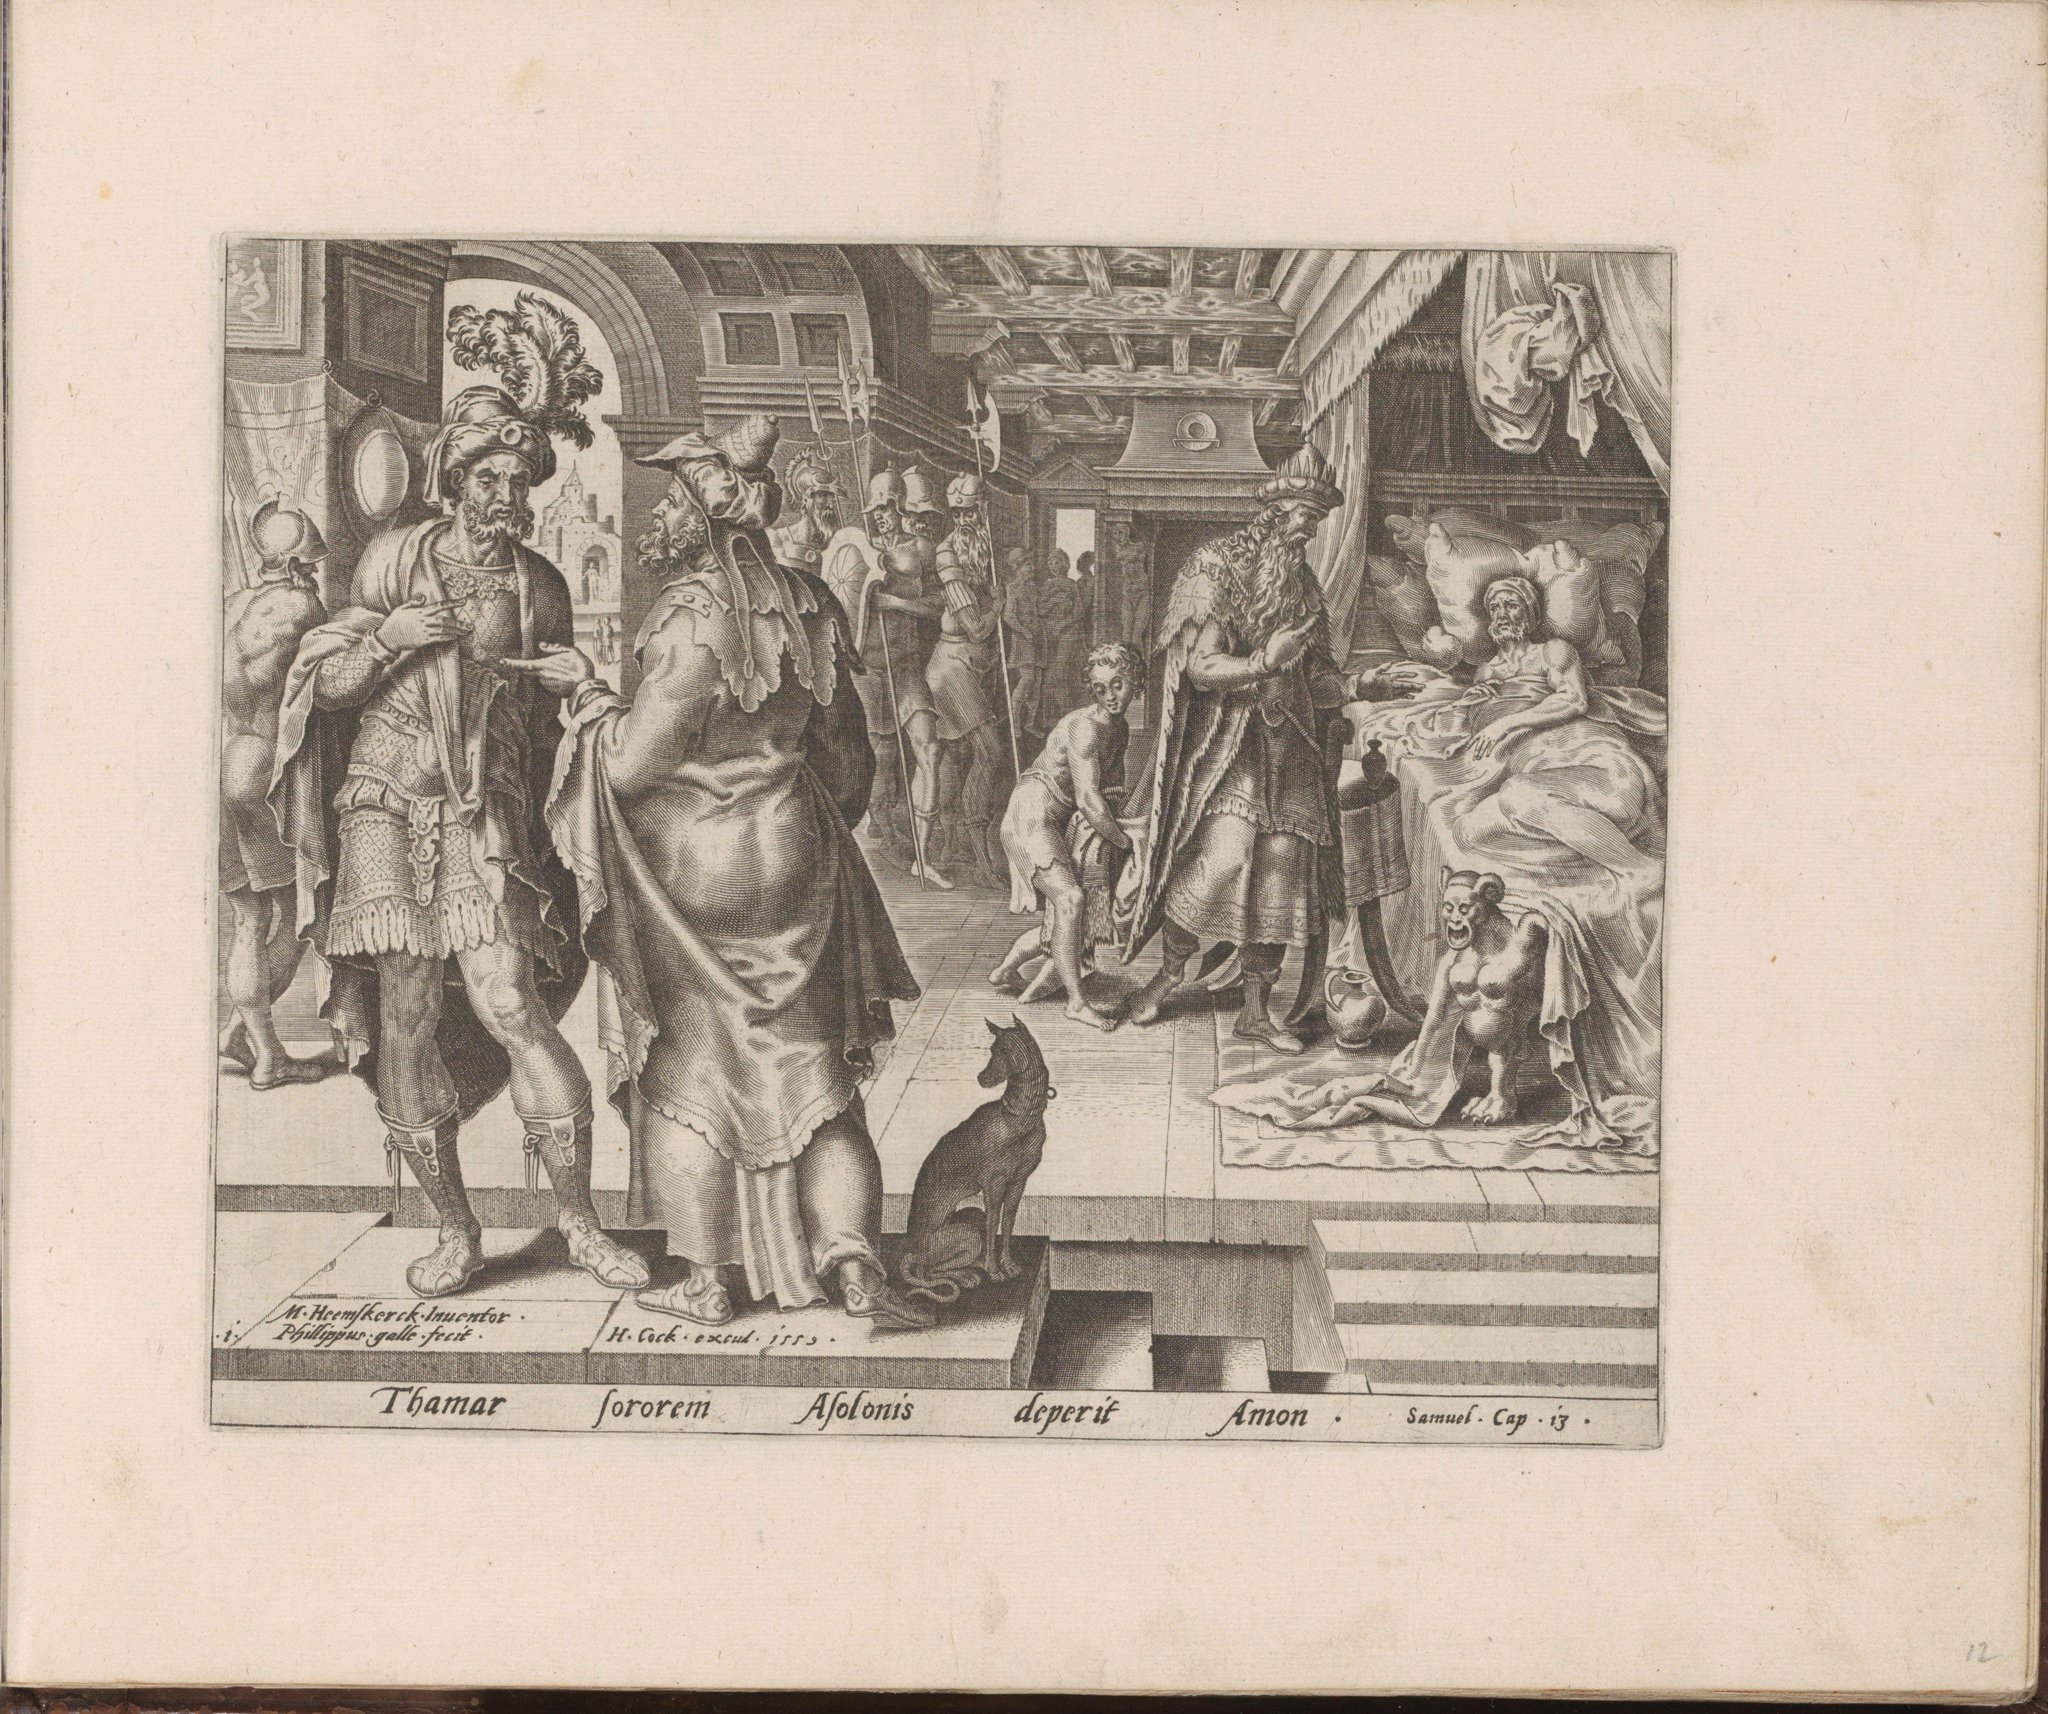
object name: print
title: Jonadab adviseert Amnon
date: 1559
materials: paper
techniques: engraving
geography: haarlem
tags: on jonadab's advice amnon pretends to be sick; david comes to his sick-bed, jonadab gives counsel to amnon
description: Amnon de oudste zoon van David is verliefd op zijn halfzus Tamar. Zijn neef Jonadab adviseert op de voorgrond Amnon ziek op bed te gaan liggen en om Tamars aanwezigheid te vragen. Rechts achter komt koning David zijn zoon Amnon die ziek op bed ligt bezoeken. Amnon vraagt of Tamar hem eten kan komen brengen. Onder de voorstelling een verwijzing in het Latijn naar de Bijbeltekst in 2 Sam. 13. Prent maakt deel uit van een album.